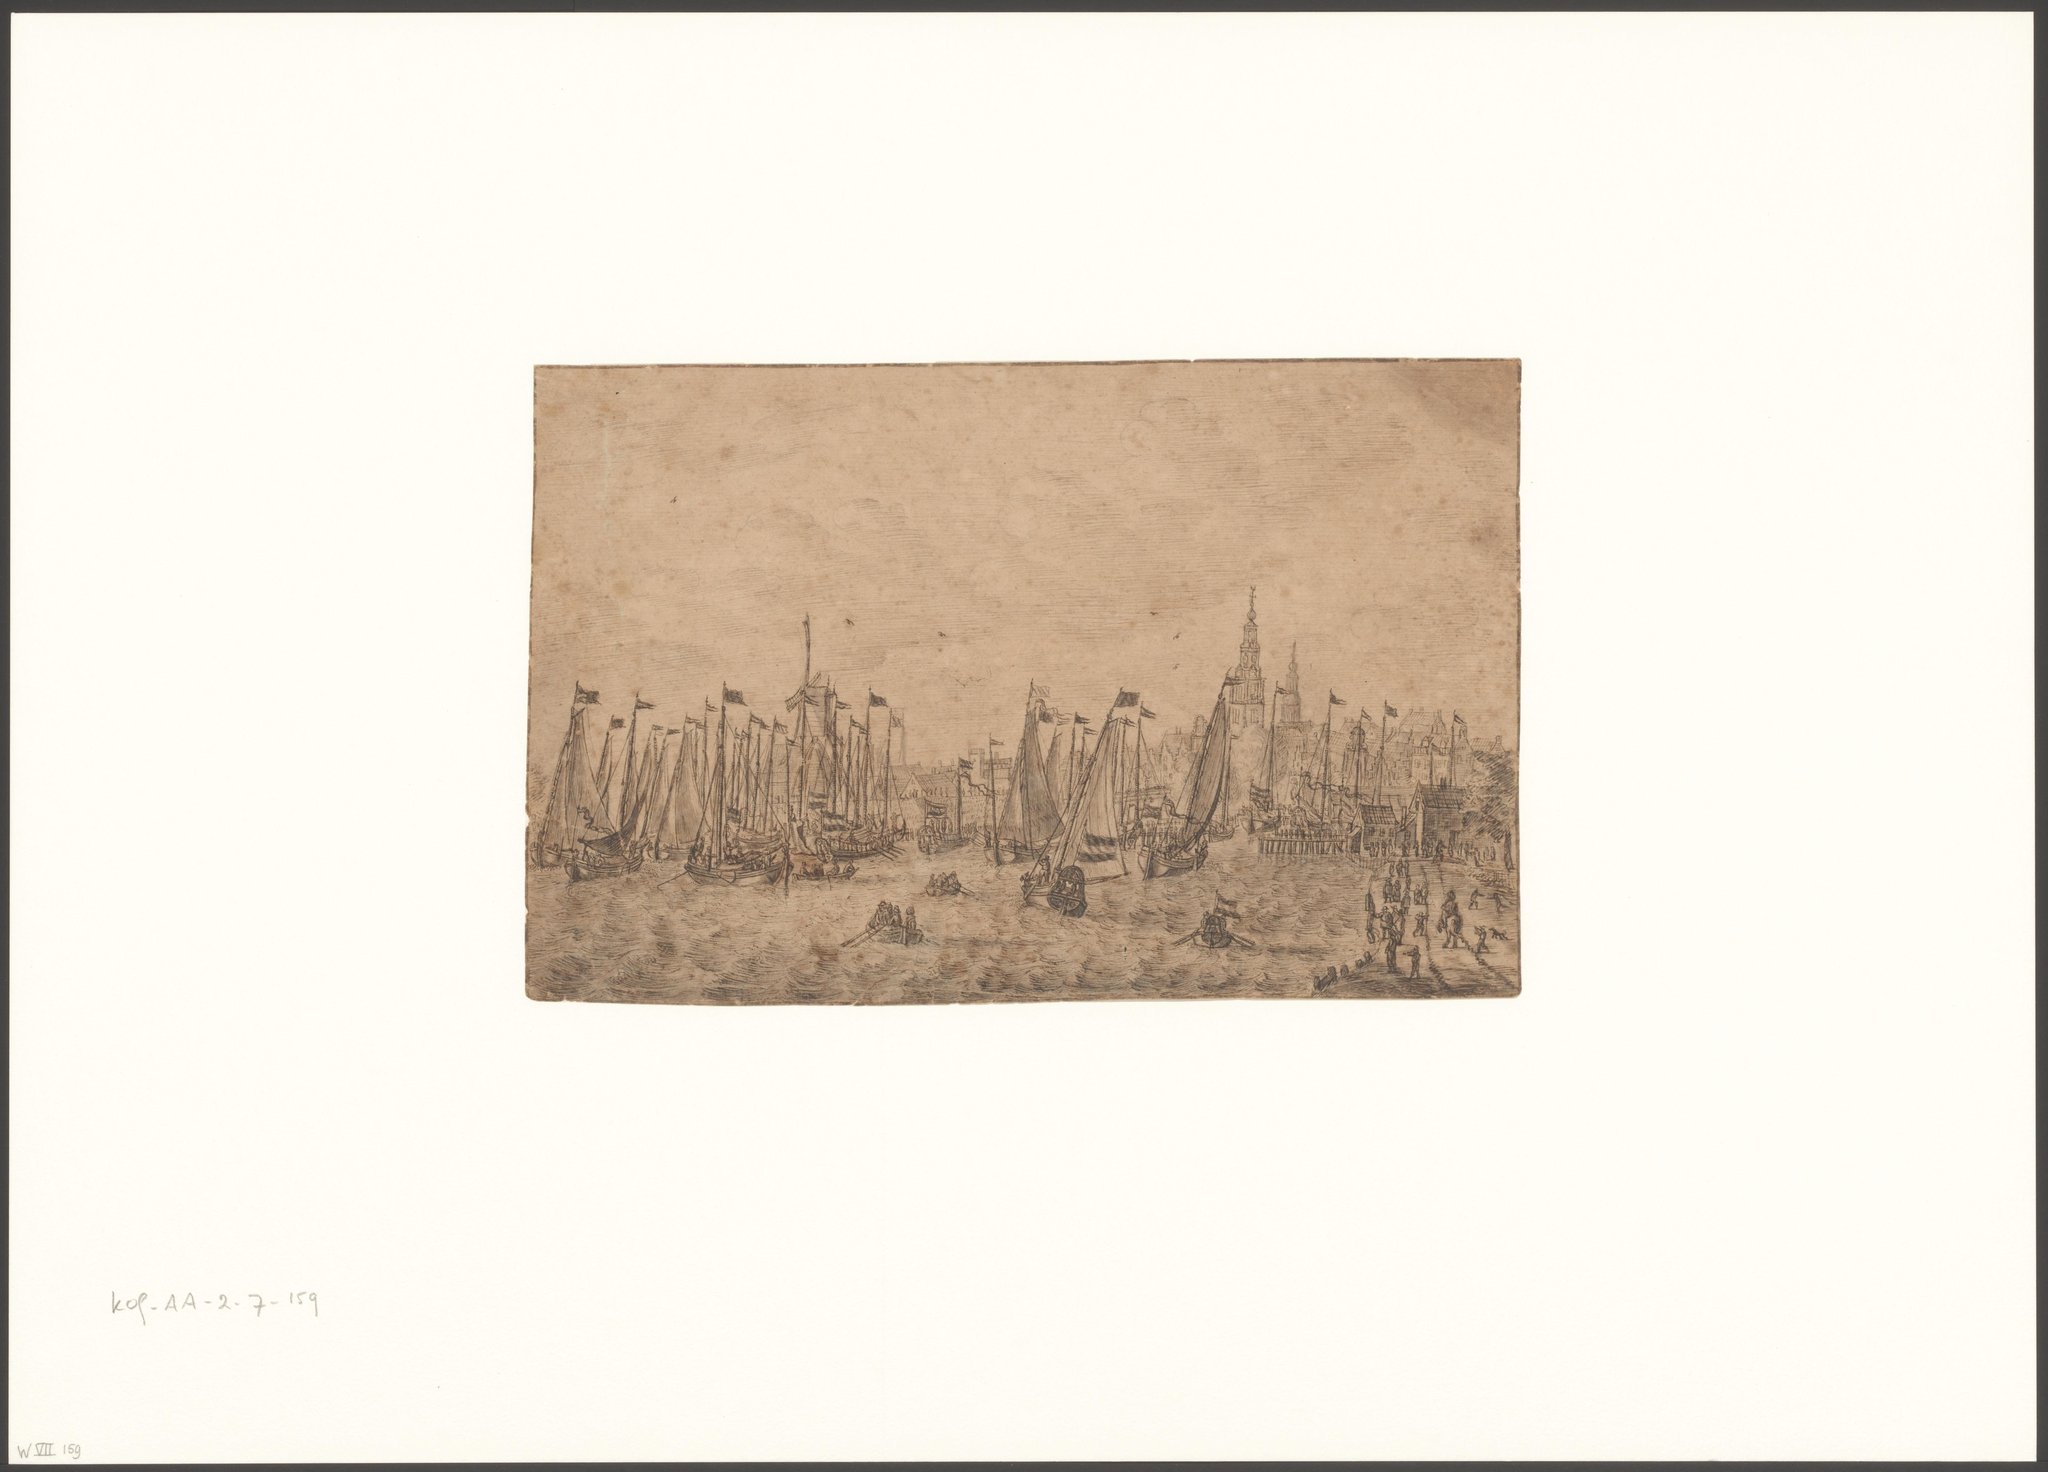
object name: drawing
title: Gezicht op een admiraalszeilen bij de jachthaven aan de Amstel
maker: Anonymous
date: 1650-1799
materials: ink, paper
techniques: pen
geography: amsterdam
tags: sailing-ship, sailing-boat, tower, clock tower ~ monumental adornment, city-view in general; 'veduta', river, windmill in landscape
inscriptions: collector's mark: Lugt 800a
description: Tekening binnen de Atlas Van Eck ingedeeld op wijknummer 7.